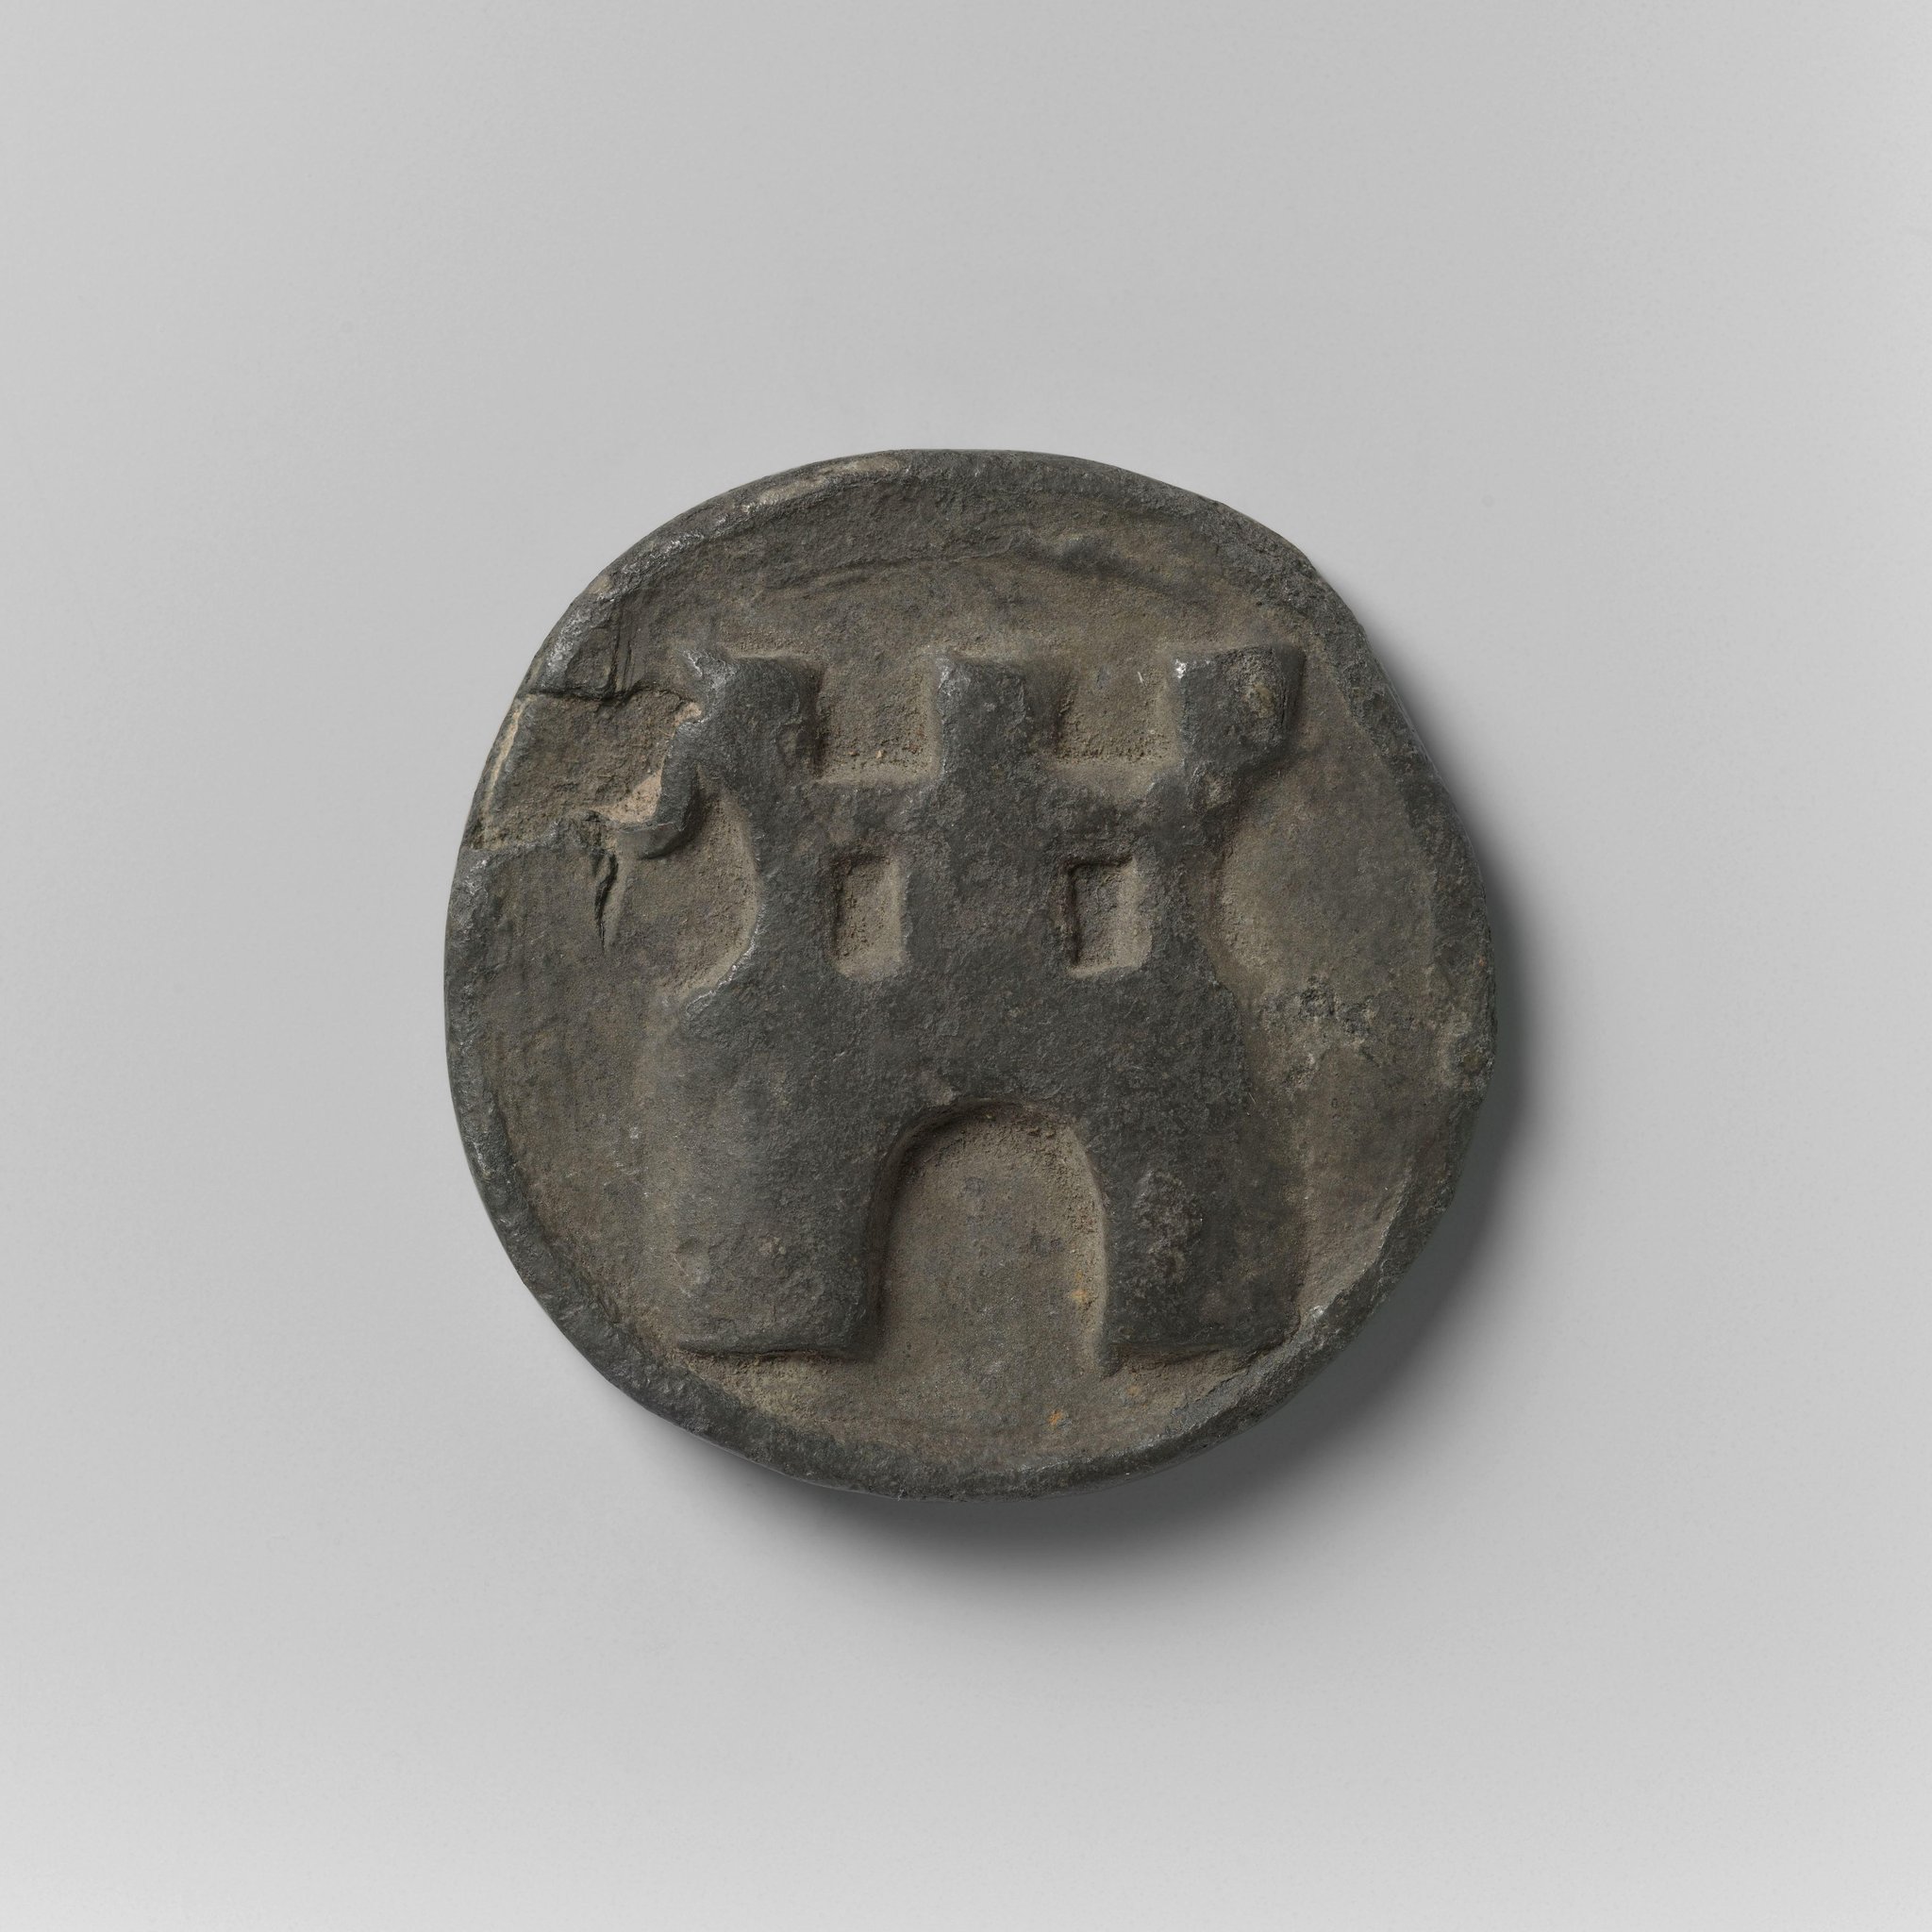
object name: history medal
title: Presentiepenning van het Bakkersgilde te Aardenburg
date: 1650-1700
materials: lead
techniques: casting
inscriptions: inscription: ‘18’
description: Gegoten loden penning, op de voorzijde een burcht, op de gladde keerzijde twee broodschieters onder een kroon, met inscriptie 18